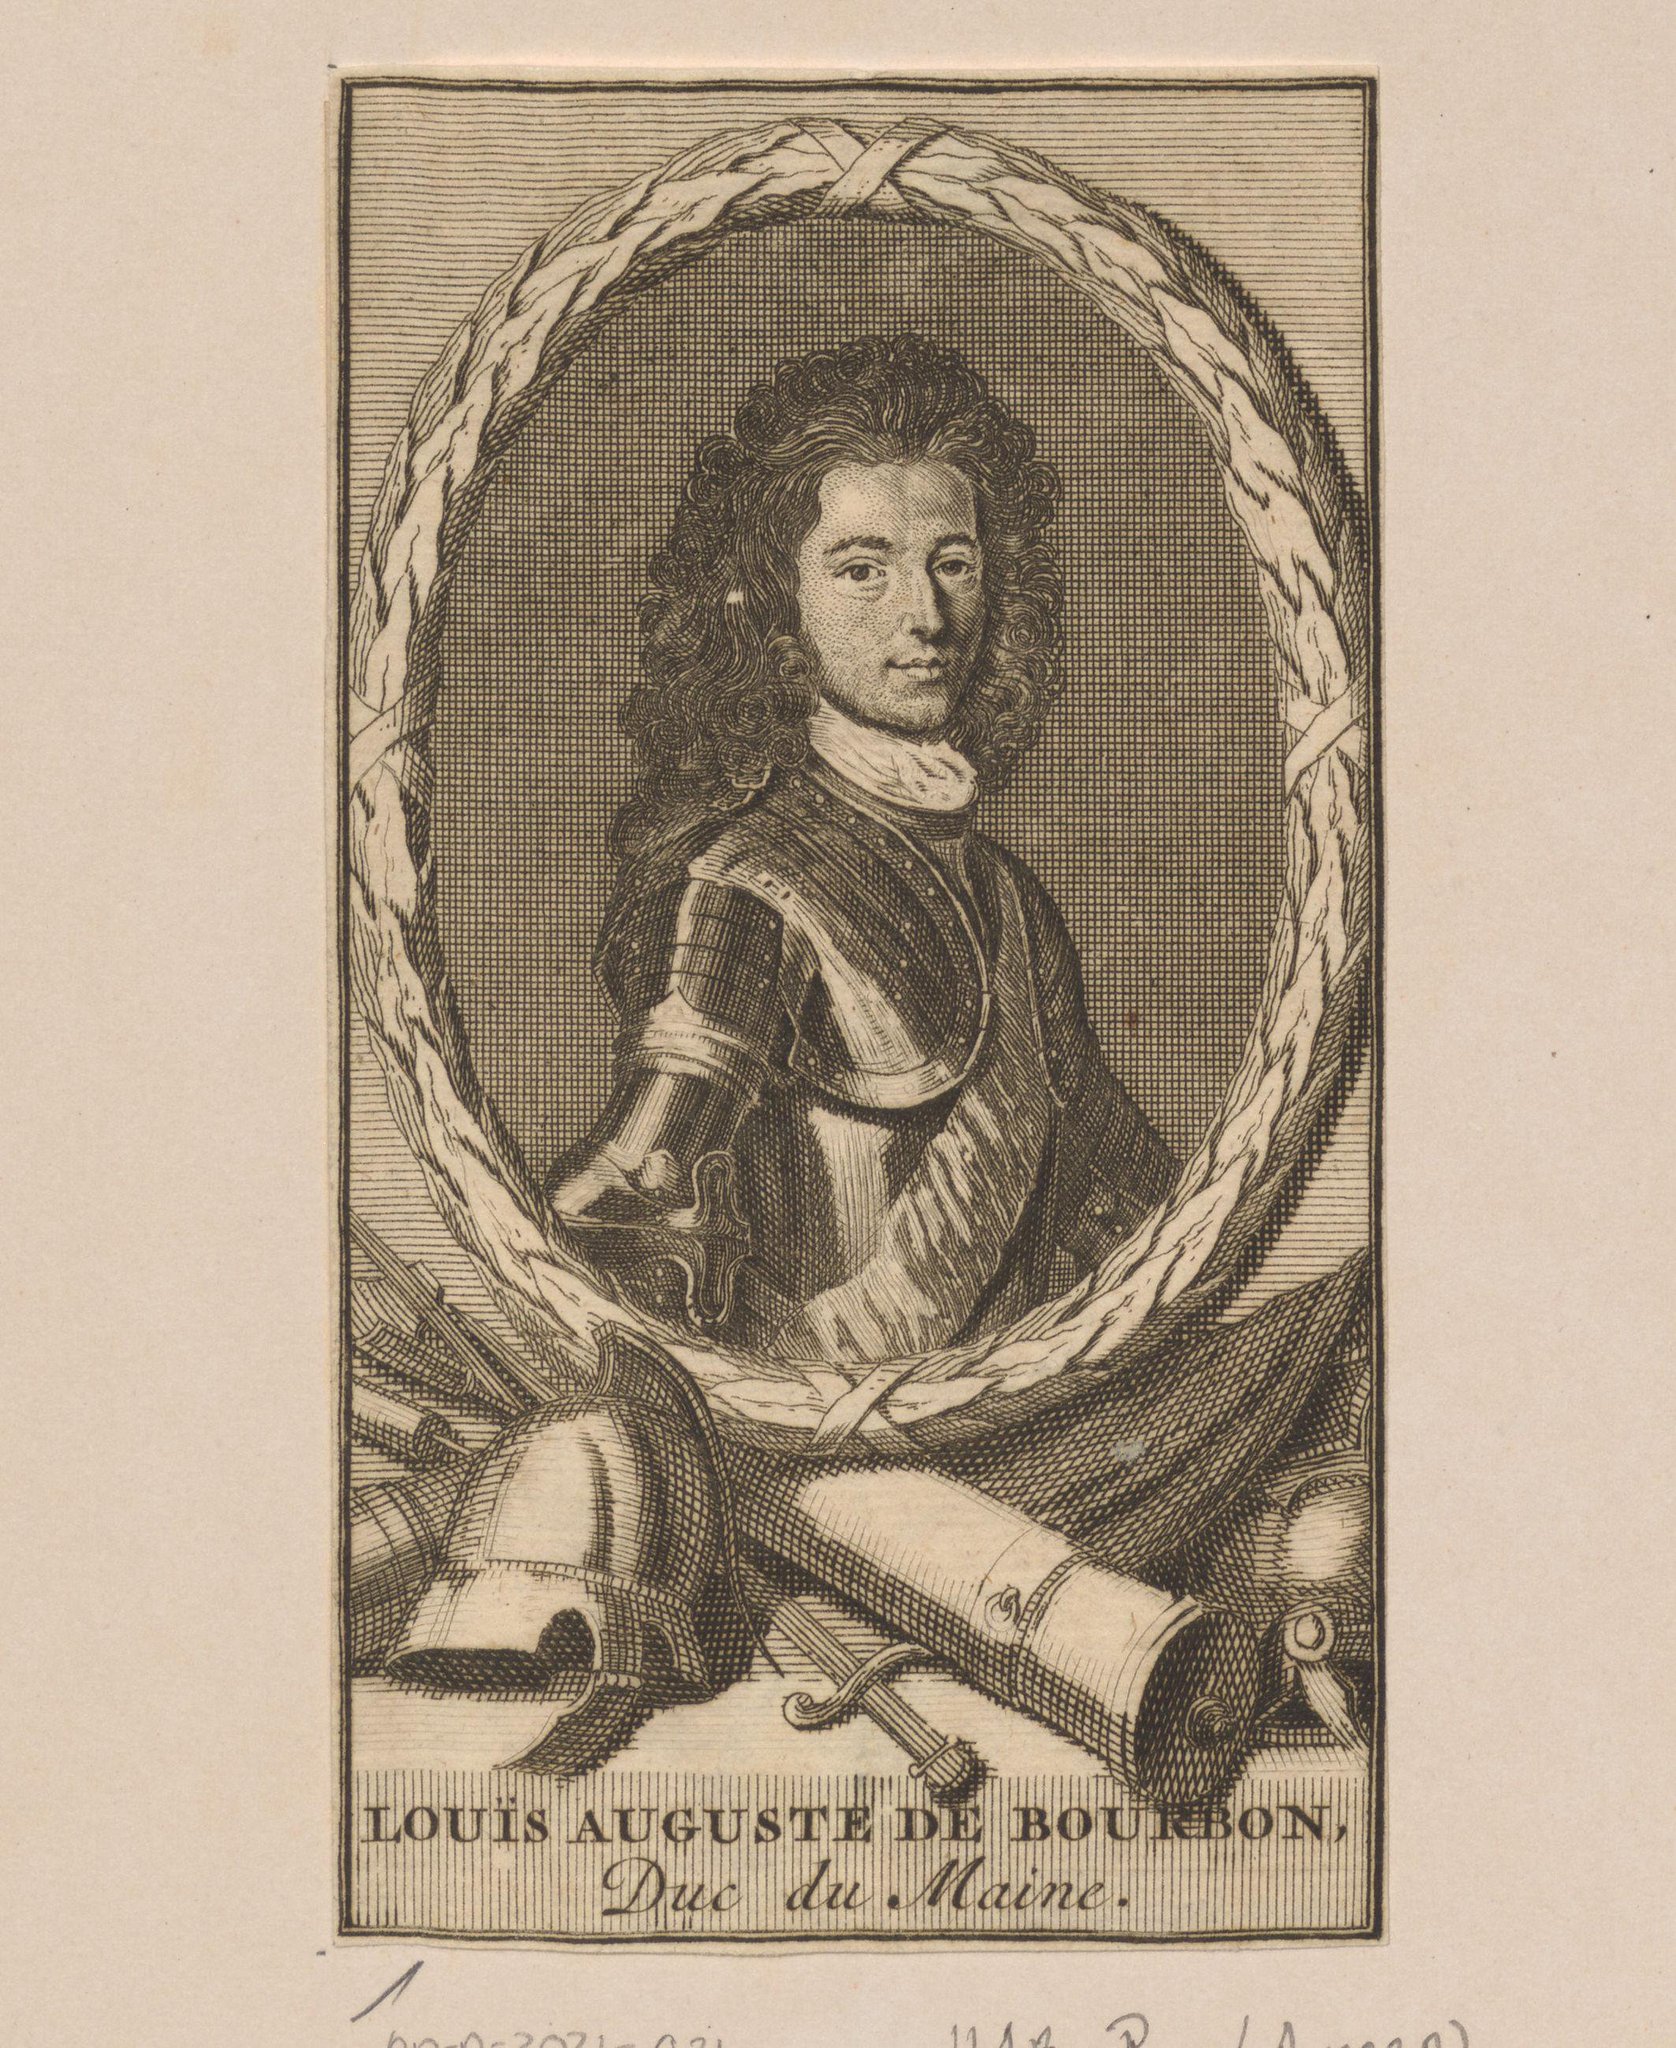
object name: print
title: Portret van Louis Auguste de Bourbon, hertog van Maine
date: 1680-1736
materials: paper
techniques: engraving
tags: louis auguste (duke of maine), historical persons